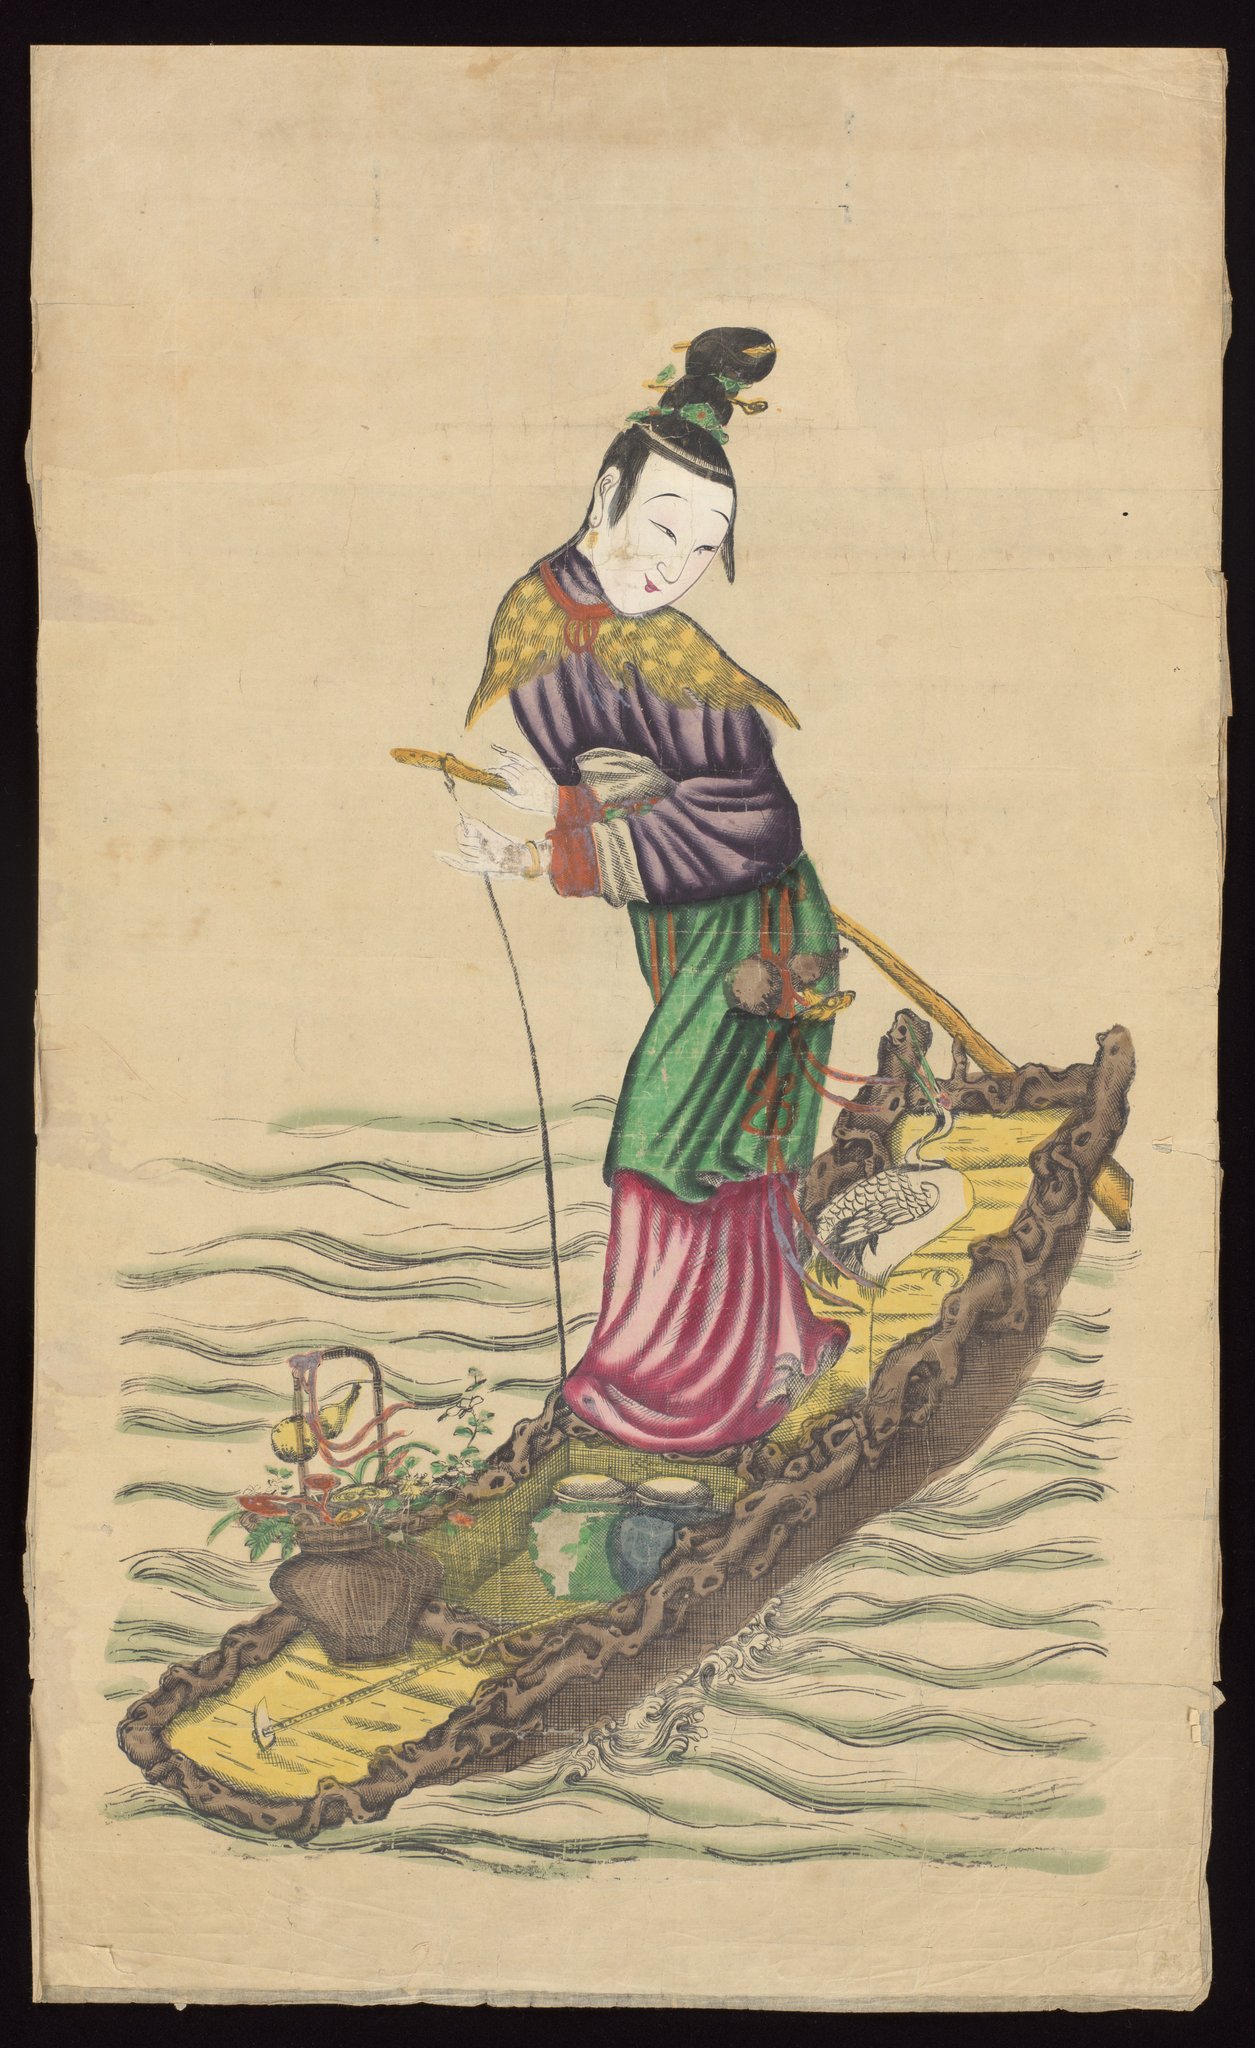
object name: print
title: Magu Bestows Longevity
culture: chinese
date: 1736-1795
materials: ink, paper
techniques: hand coloring, woodblock print